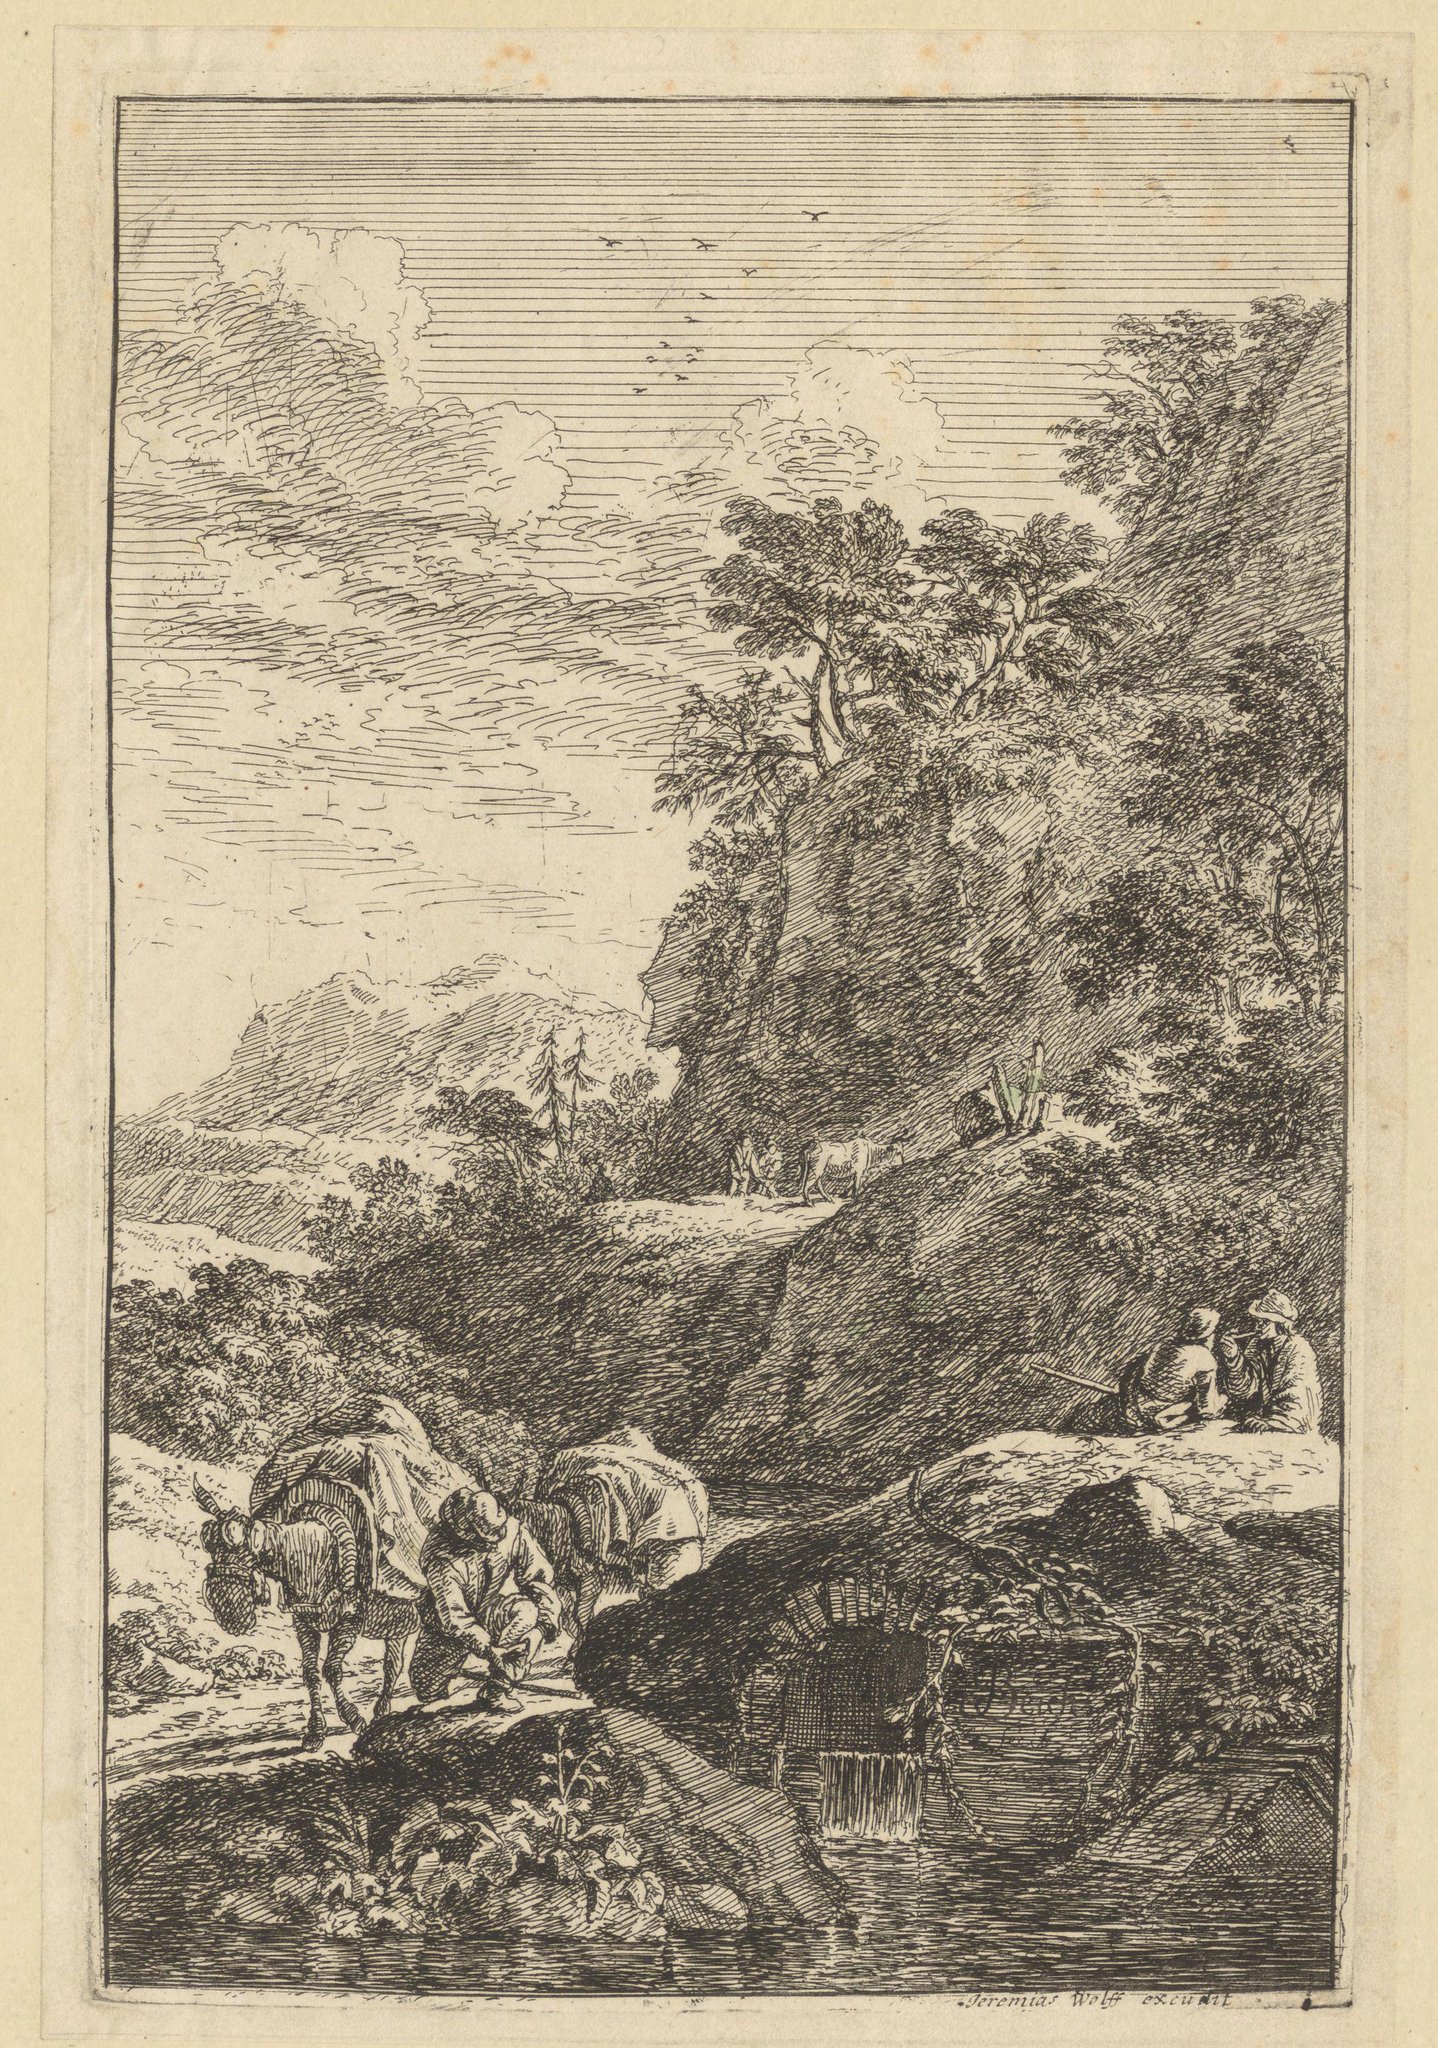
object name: print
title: Rotsachtig landschap met een reiziger met twee muildieren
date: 1714-1724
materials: paper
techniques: etching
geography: munich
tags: mountains (+ landscape with figures, staffage), 'en route', traveller under way, mule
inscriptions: collector's mark: Lugt 240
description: Eerste prent uit de serie 'Landschappen in de stijl van Salvator Rosa', bestaand uit zes prenten.